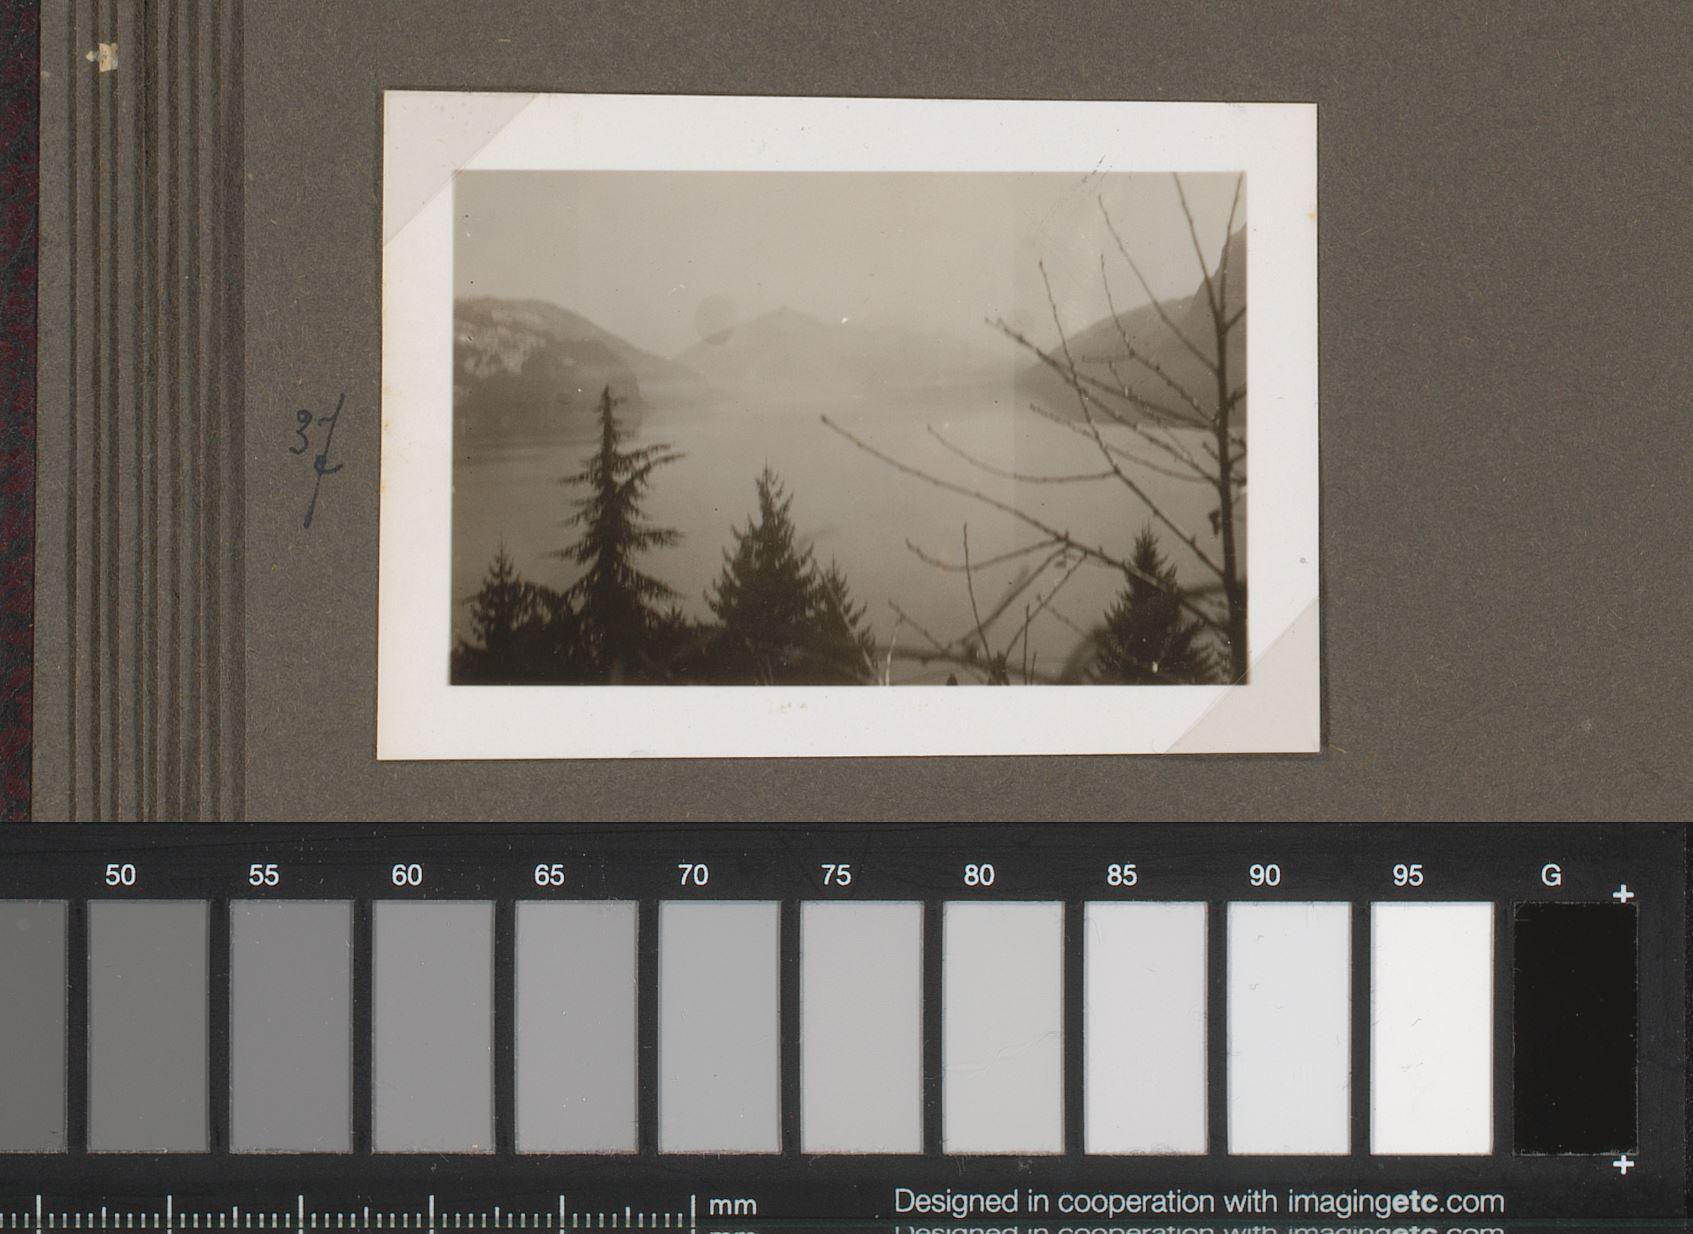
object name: photograph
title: Gezicht op Castagnola, Zwitserland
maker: Anonymous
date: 1934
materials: photographic support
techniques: gelatin silver print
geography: castagnola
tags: lake, snow, mountains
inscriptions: number: ‘37’